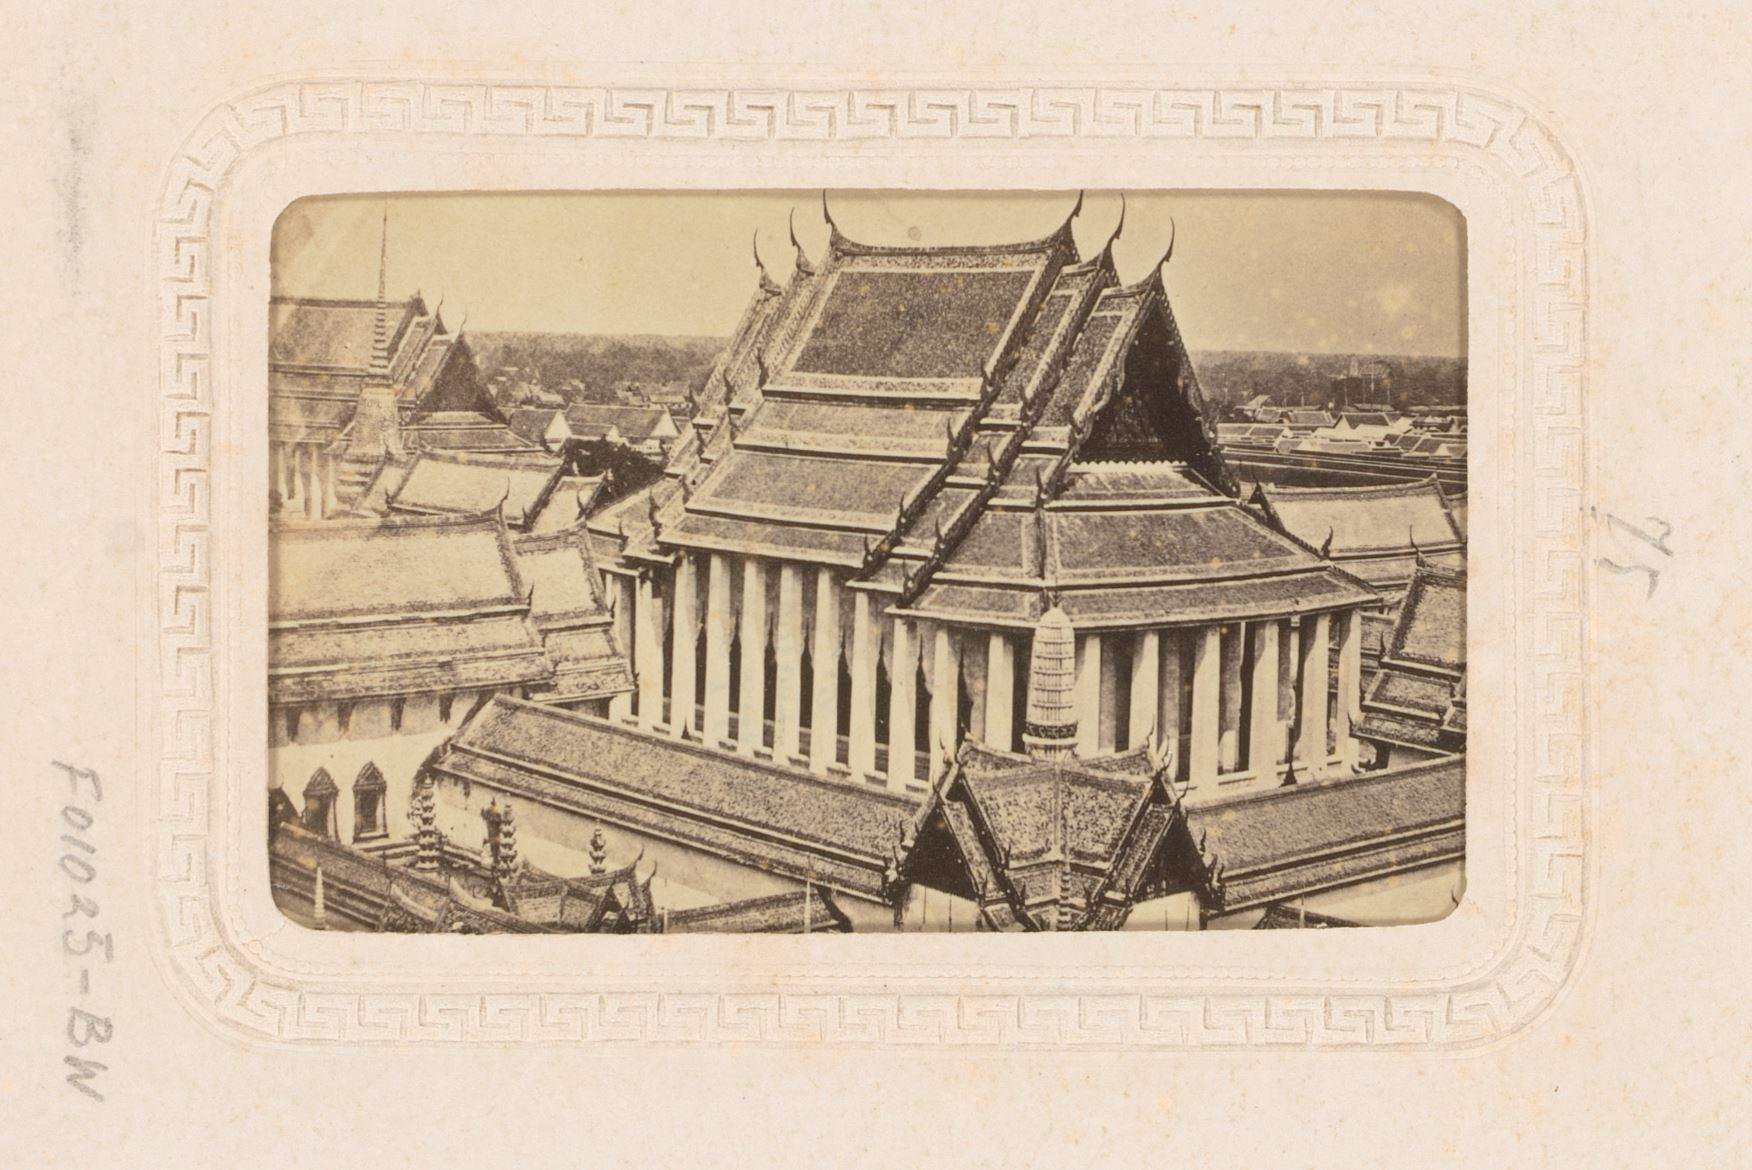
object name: photograph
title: Gezicht op het Koninklijk Paleis te Bangkok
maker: Anonymous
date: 1850-1880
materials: cardboard, photographic support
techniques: albumen print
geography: bangkok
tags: palace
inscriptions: number: ‘75’, annotation: ‘1 Siameschis haus/ Bangkok’